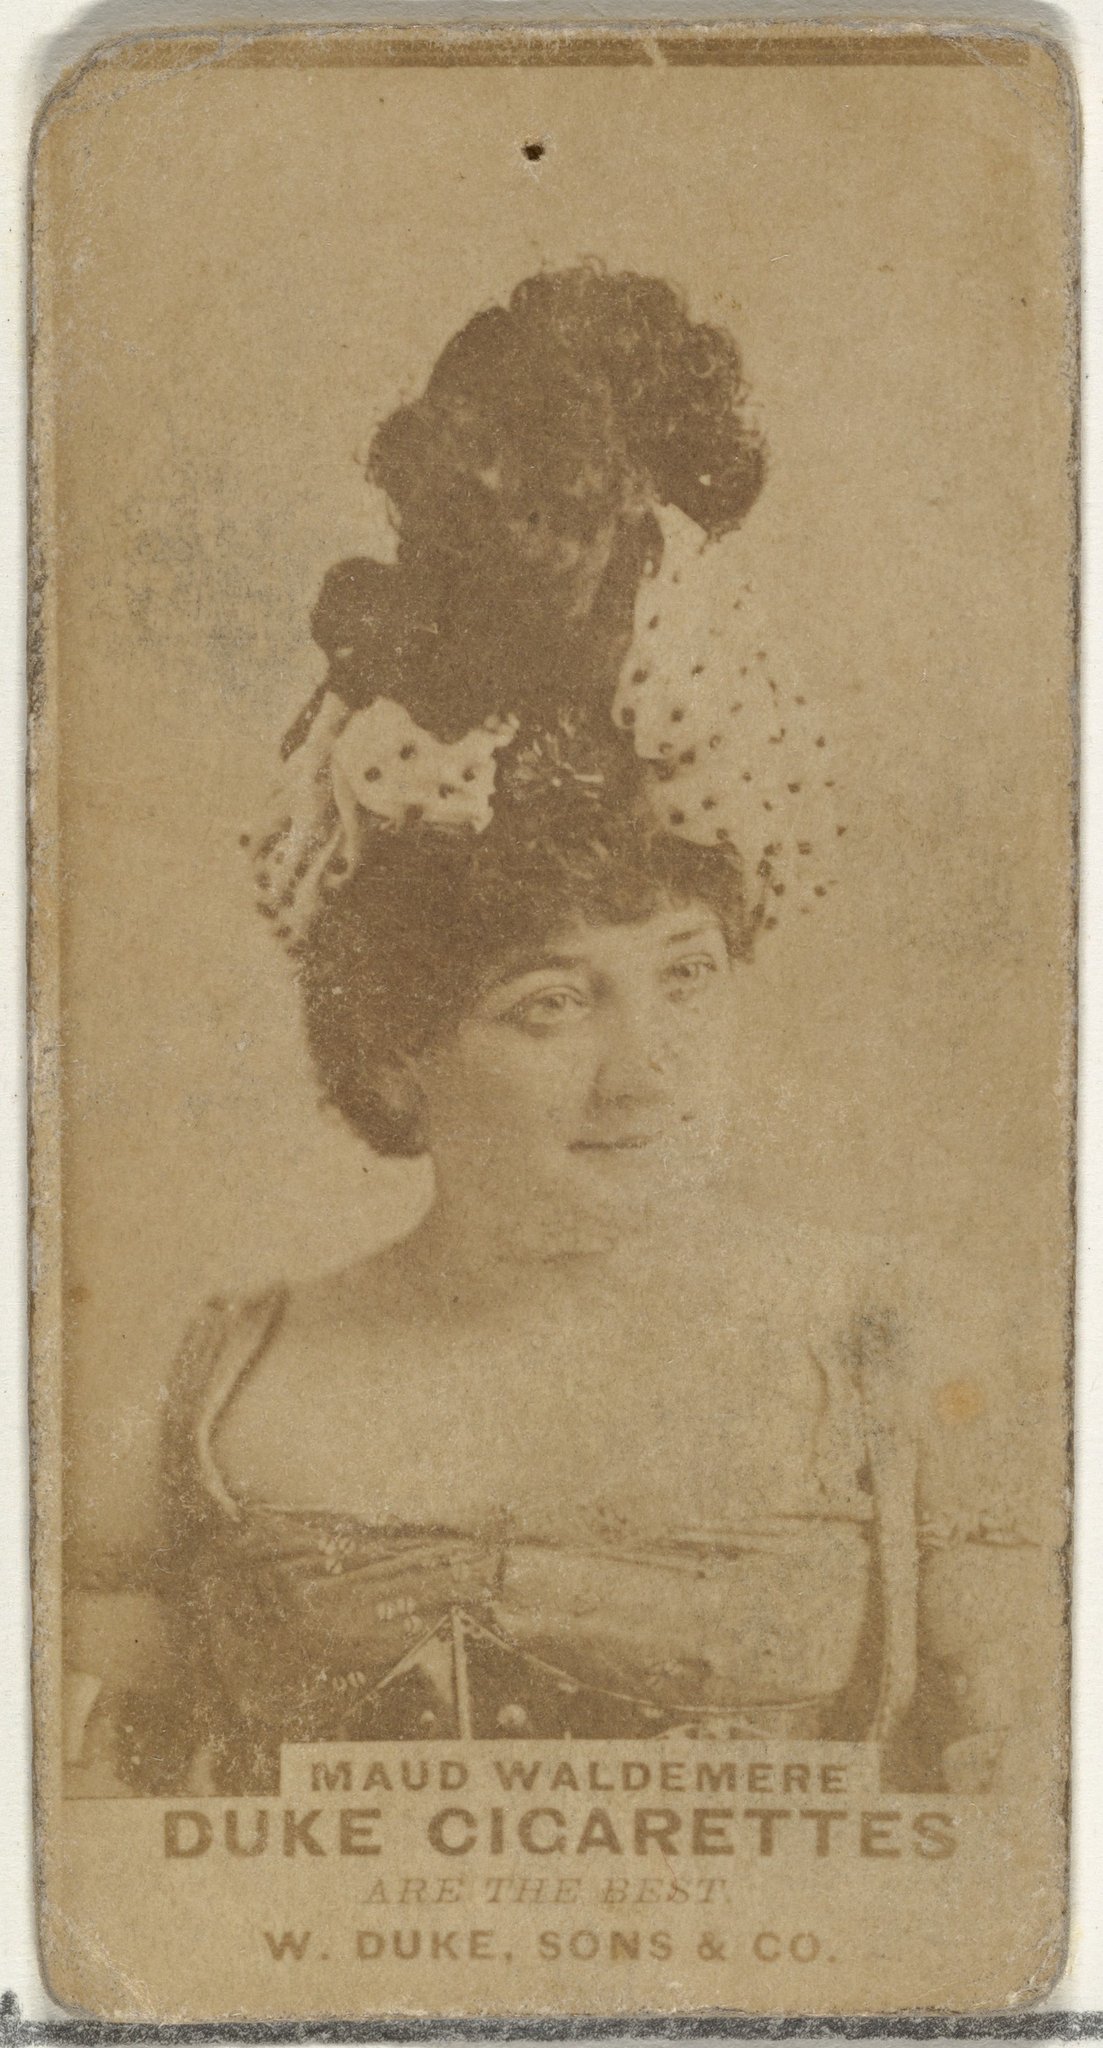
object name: photograph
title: Maud Waldemere, from the Actors and Actresses series (N145-7) issued by Duke Sons & Co. to promote Duke Cigarettes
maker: w. duke, sons & co.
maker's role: publisher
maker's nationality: american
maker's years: 1870-1920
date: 1880-1889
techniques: albumen silver print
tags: portraits,women,actresses